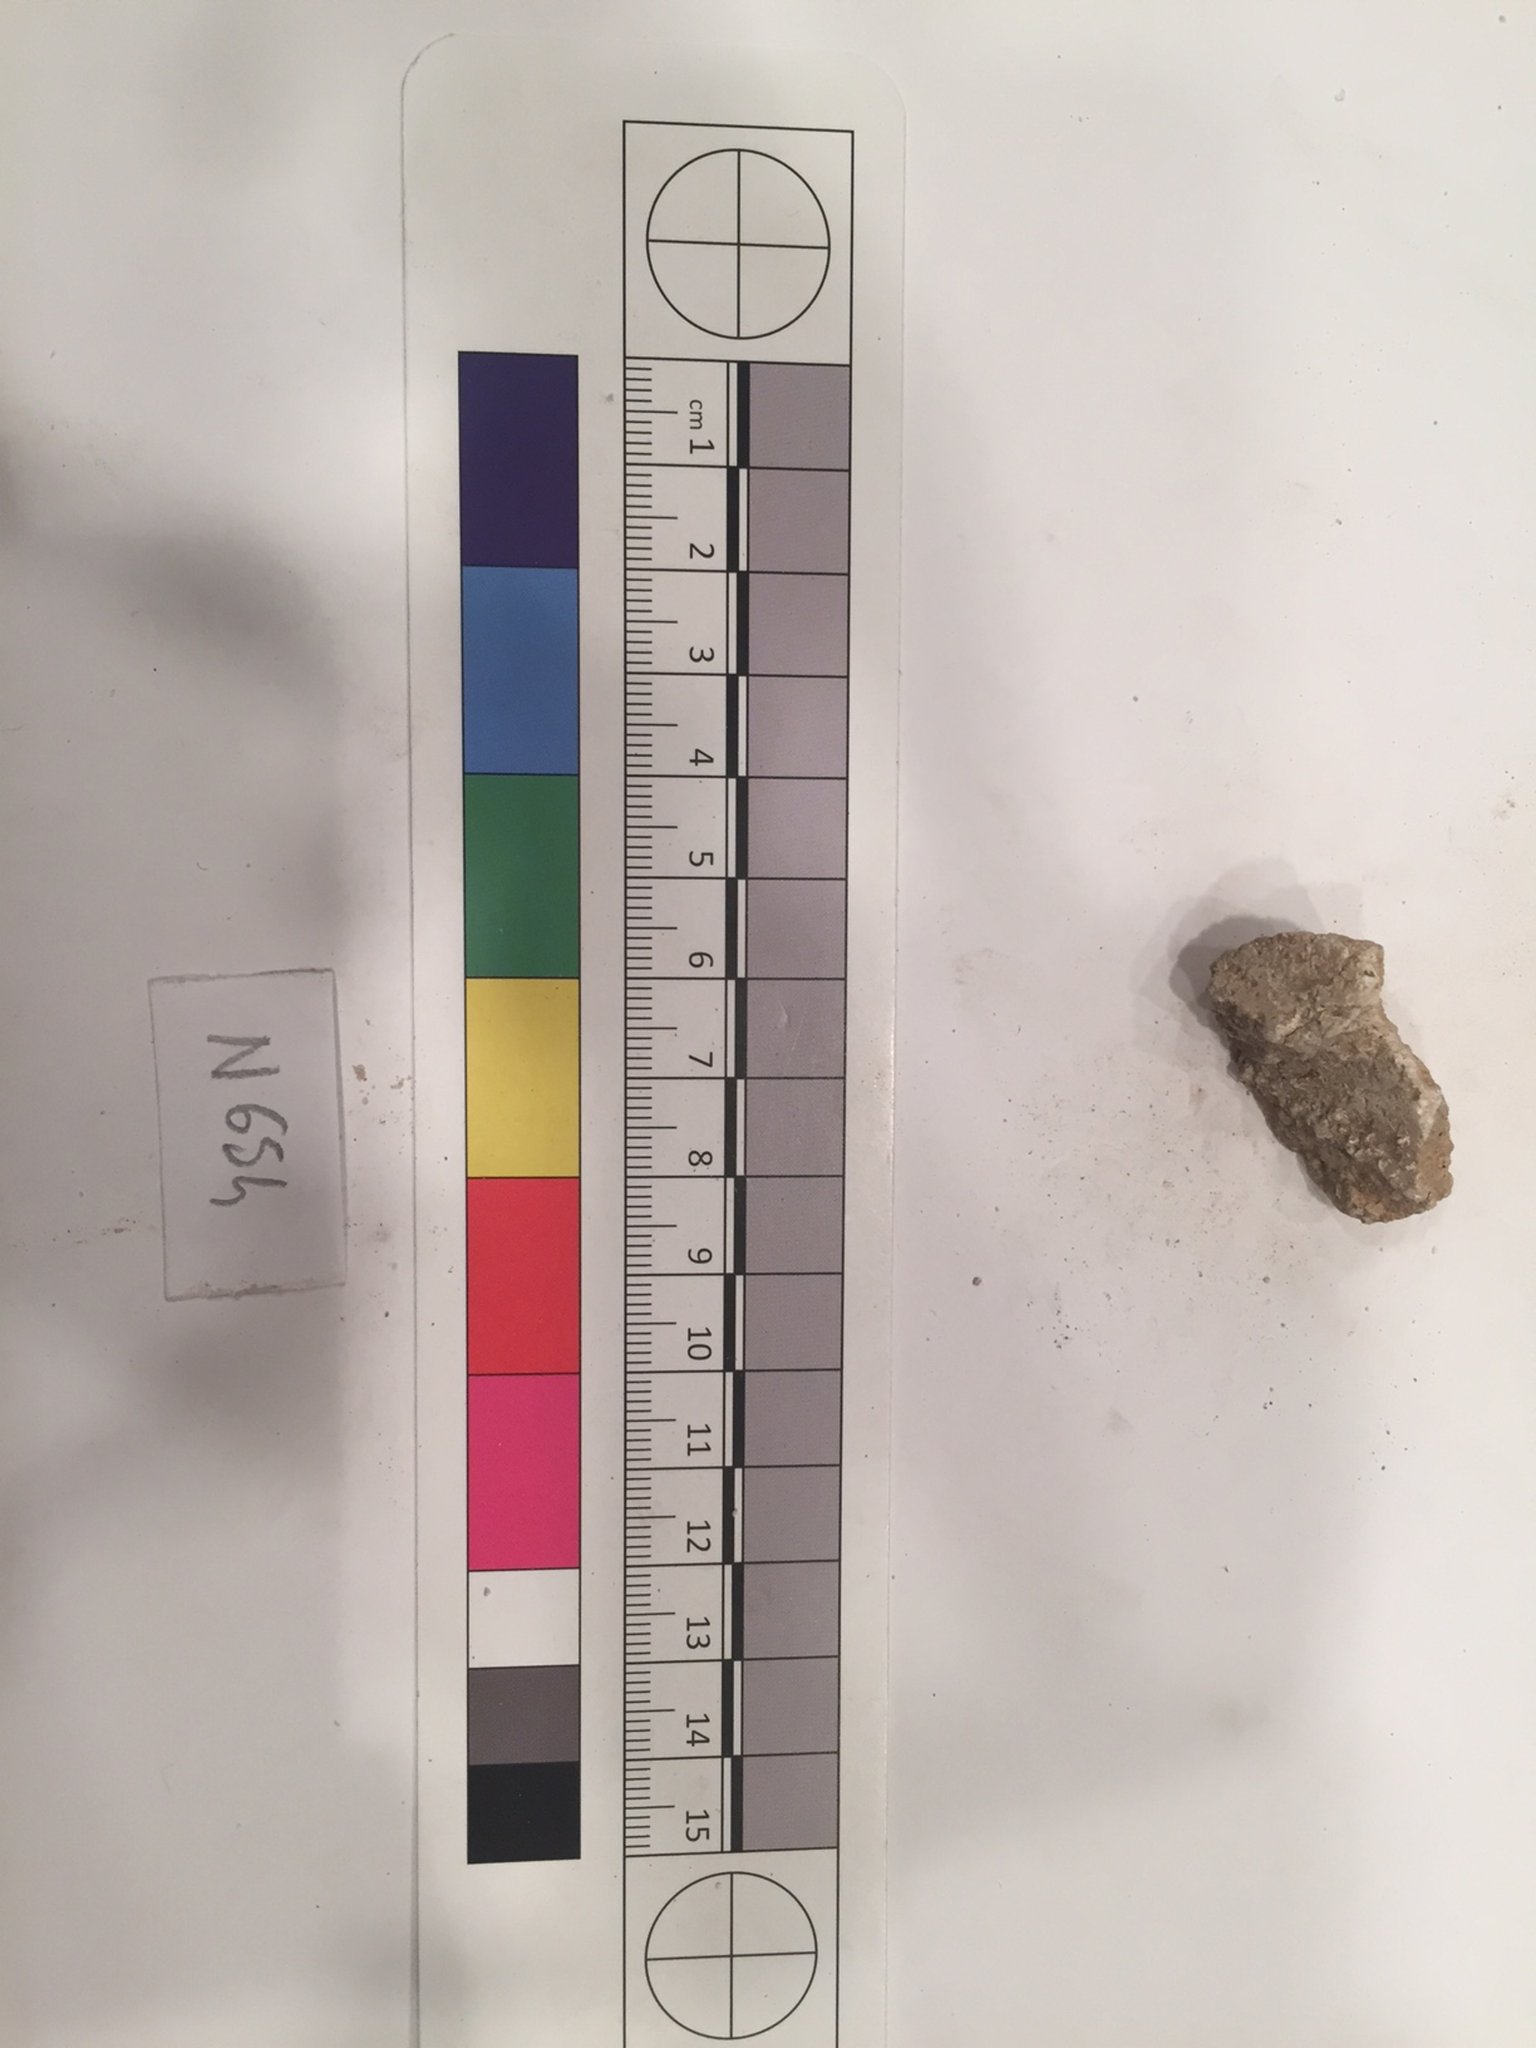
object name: fragment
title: Stucco Fragment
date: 701-1200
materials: plaster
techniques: carving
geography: iran